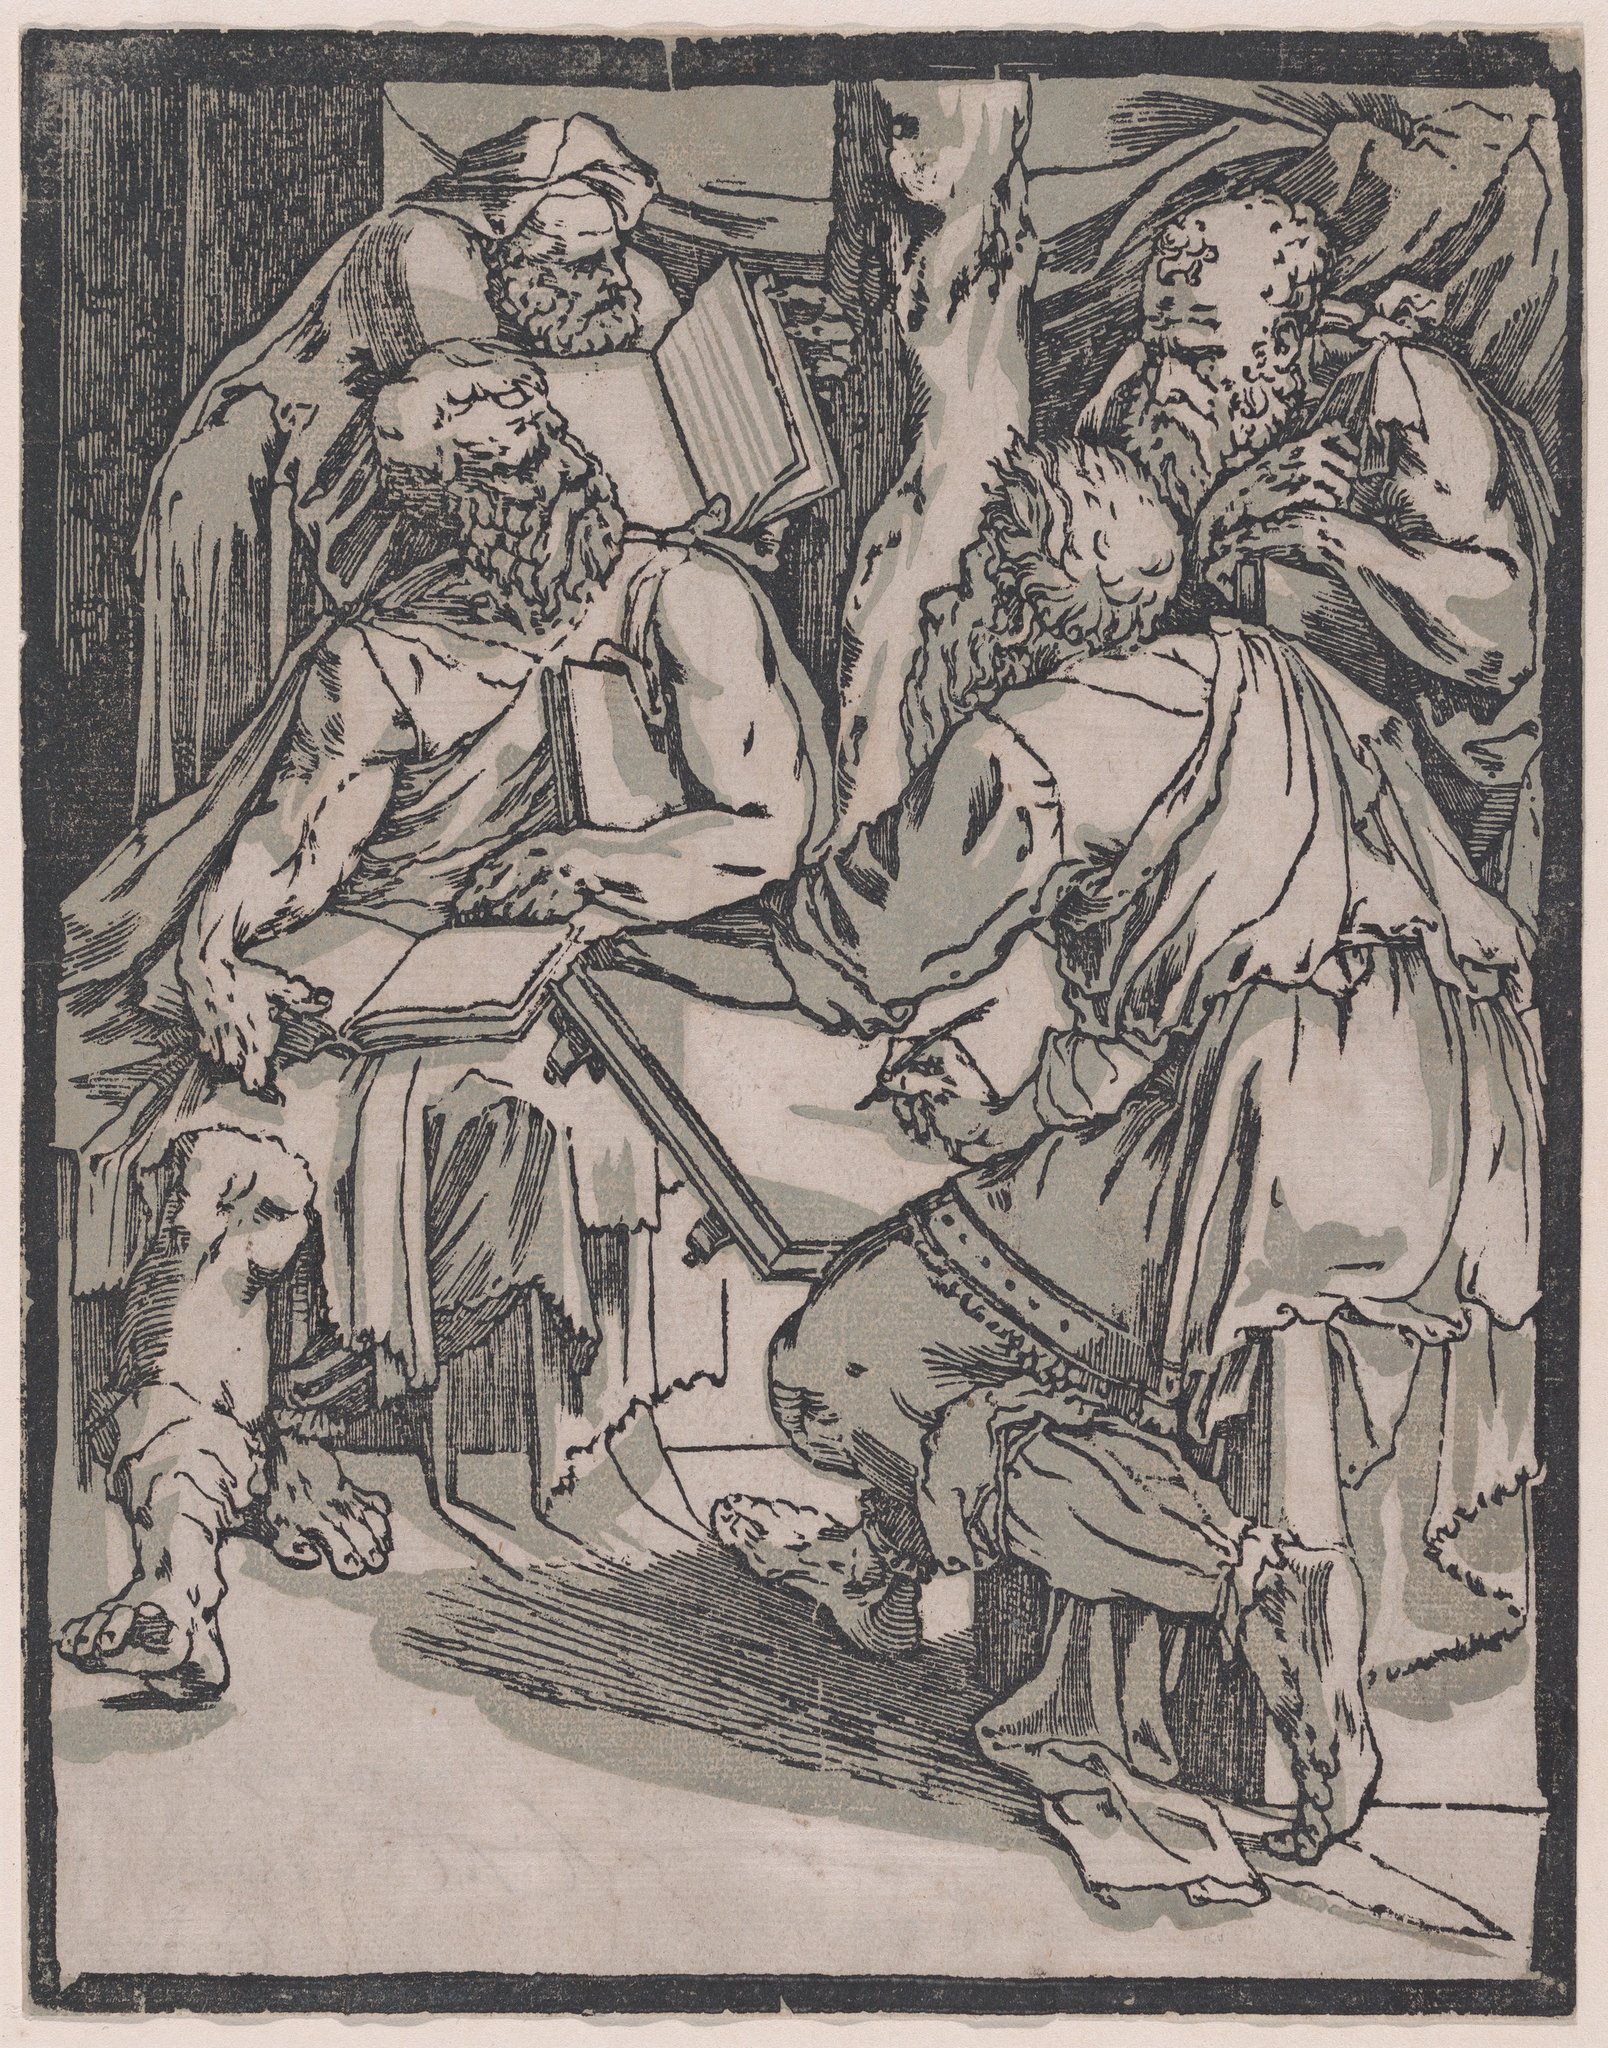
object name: print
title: Four Doctors of the Church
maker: domenico beccafumi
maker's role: artist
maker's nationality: italian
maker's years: 1484-1551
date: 1540-1550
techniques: woodcut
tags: men,doctors